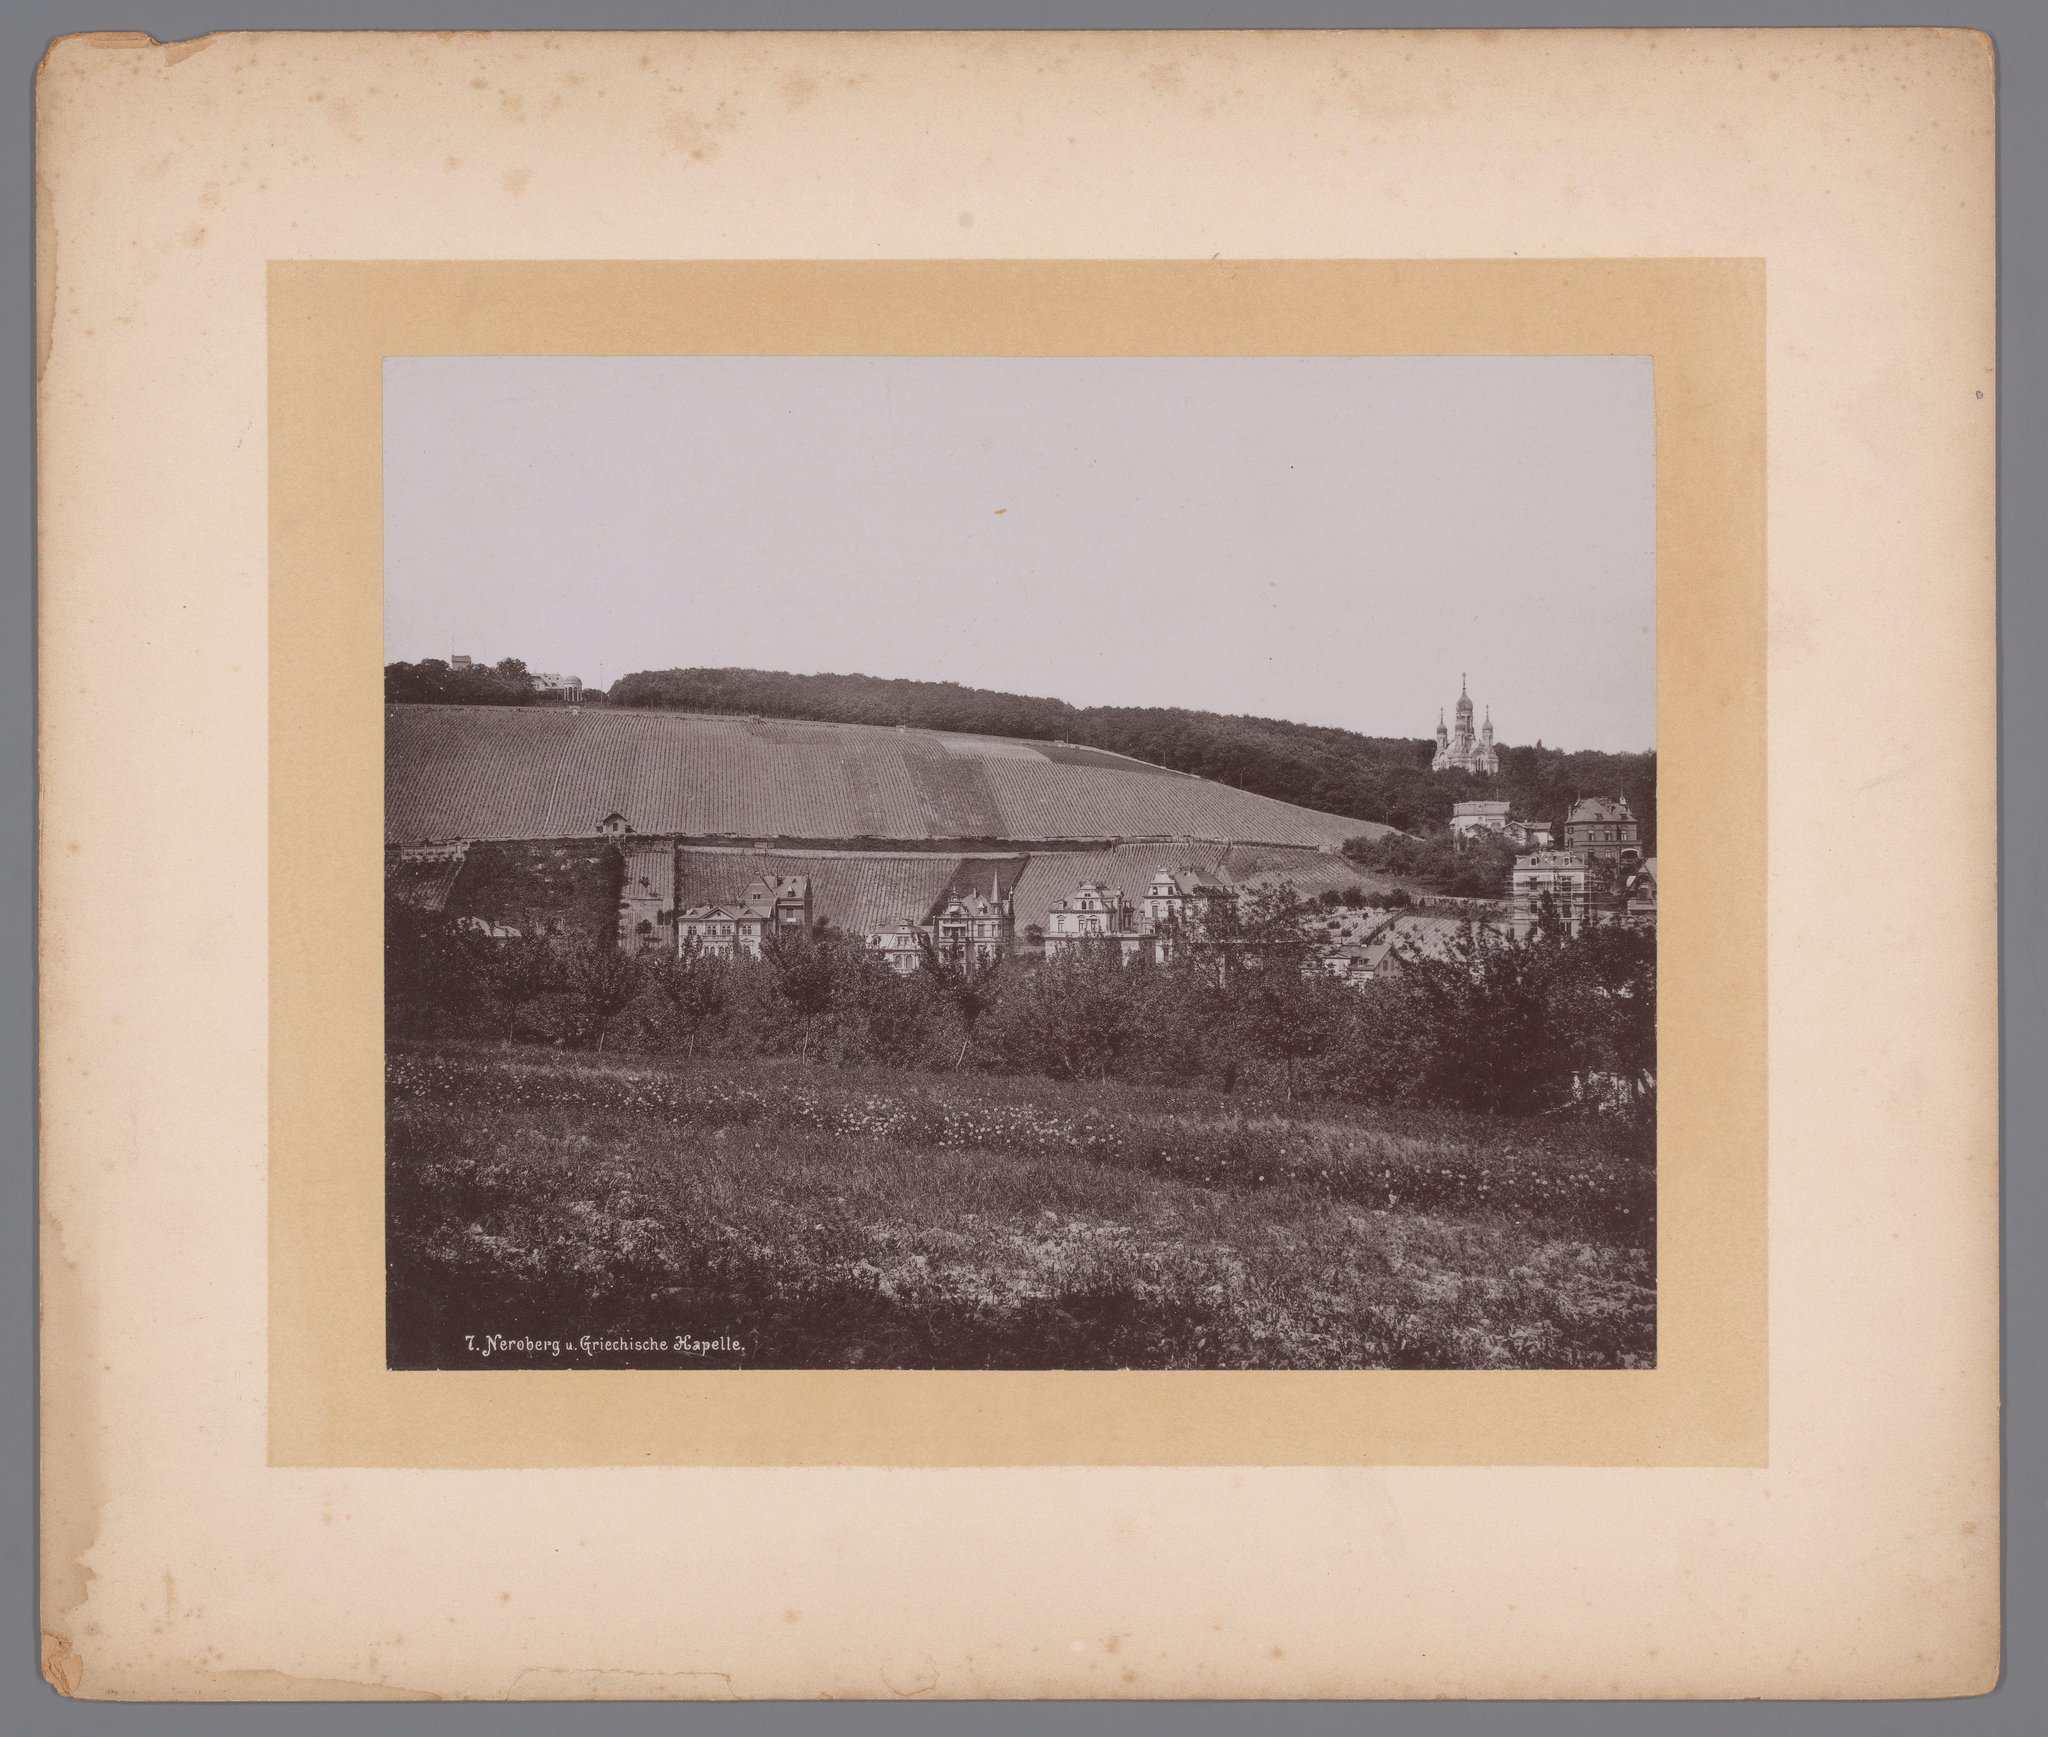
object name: photograph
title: 'Griechische Kapelle'/Russisch-orthodoxe Kerk op de Neroberg, Wiesbaden, Duitsland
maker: Anonymous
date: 1890-1900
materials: cardboard, paper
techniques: photograph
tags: wiesbaden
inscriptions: inscription: ‘7. Neroberg u. Griechische Kapelle.’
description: Foutief 'Griekse Kapel' genoemde Russisch-orthodoxe kerk "der heiligen Elisabeth in Wiesbaden", die Adolf von Nassau als graf voor zijn jong overleden vrouw Elisabeta Michailovna (dochter van de jongere broer van de tsaren Alexander I en Nicolaas I van Rusland) tussen 1847-1855 liet bouwen.